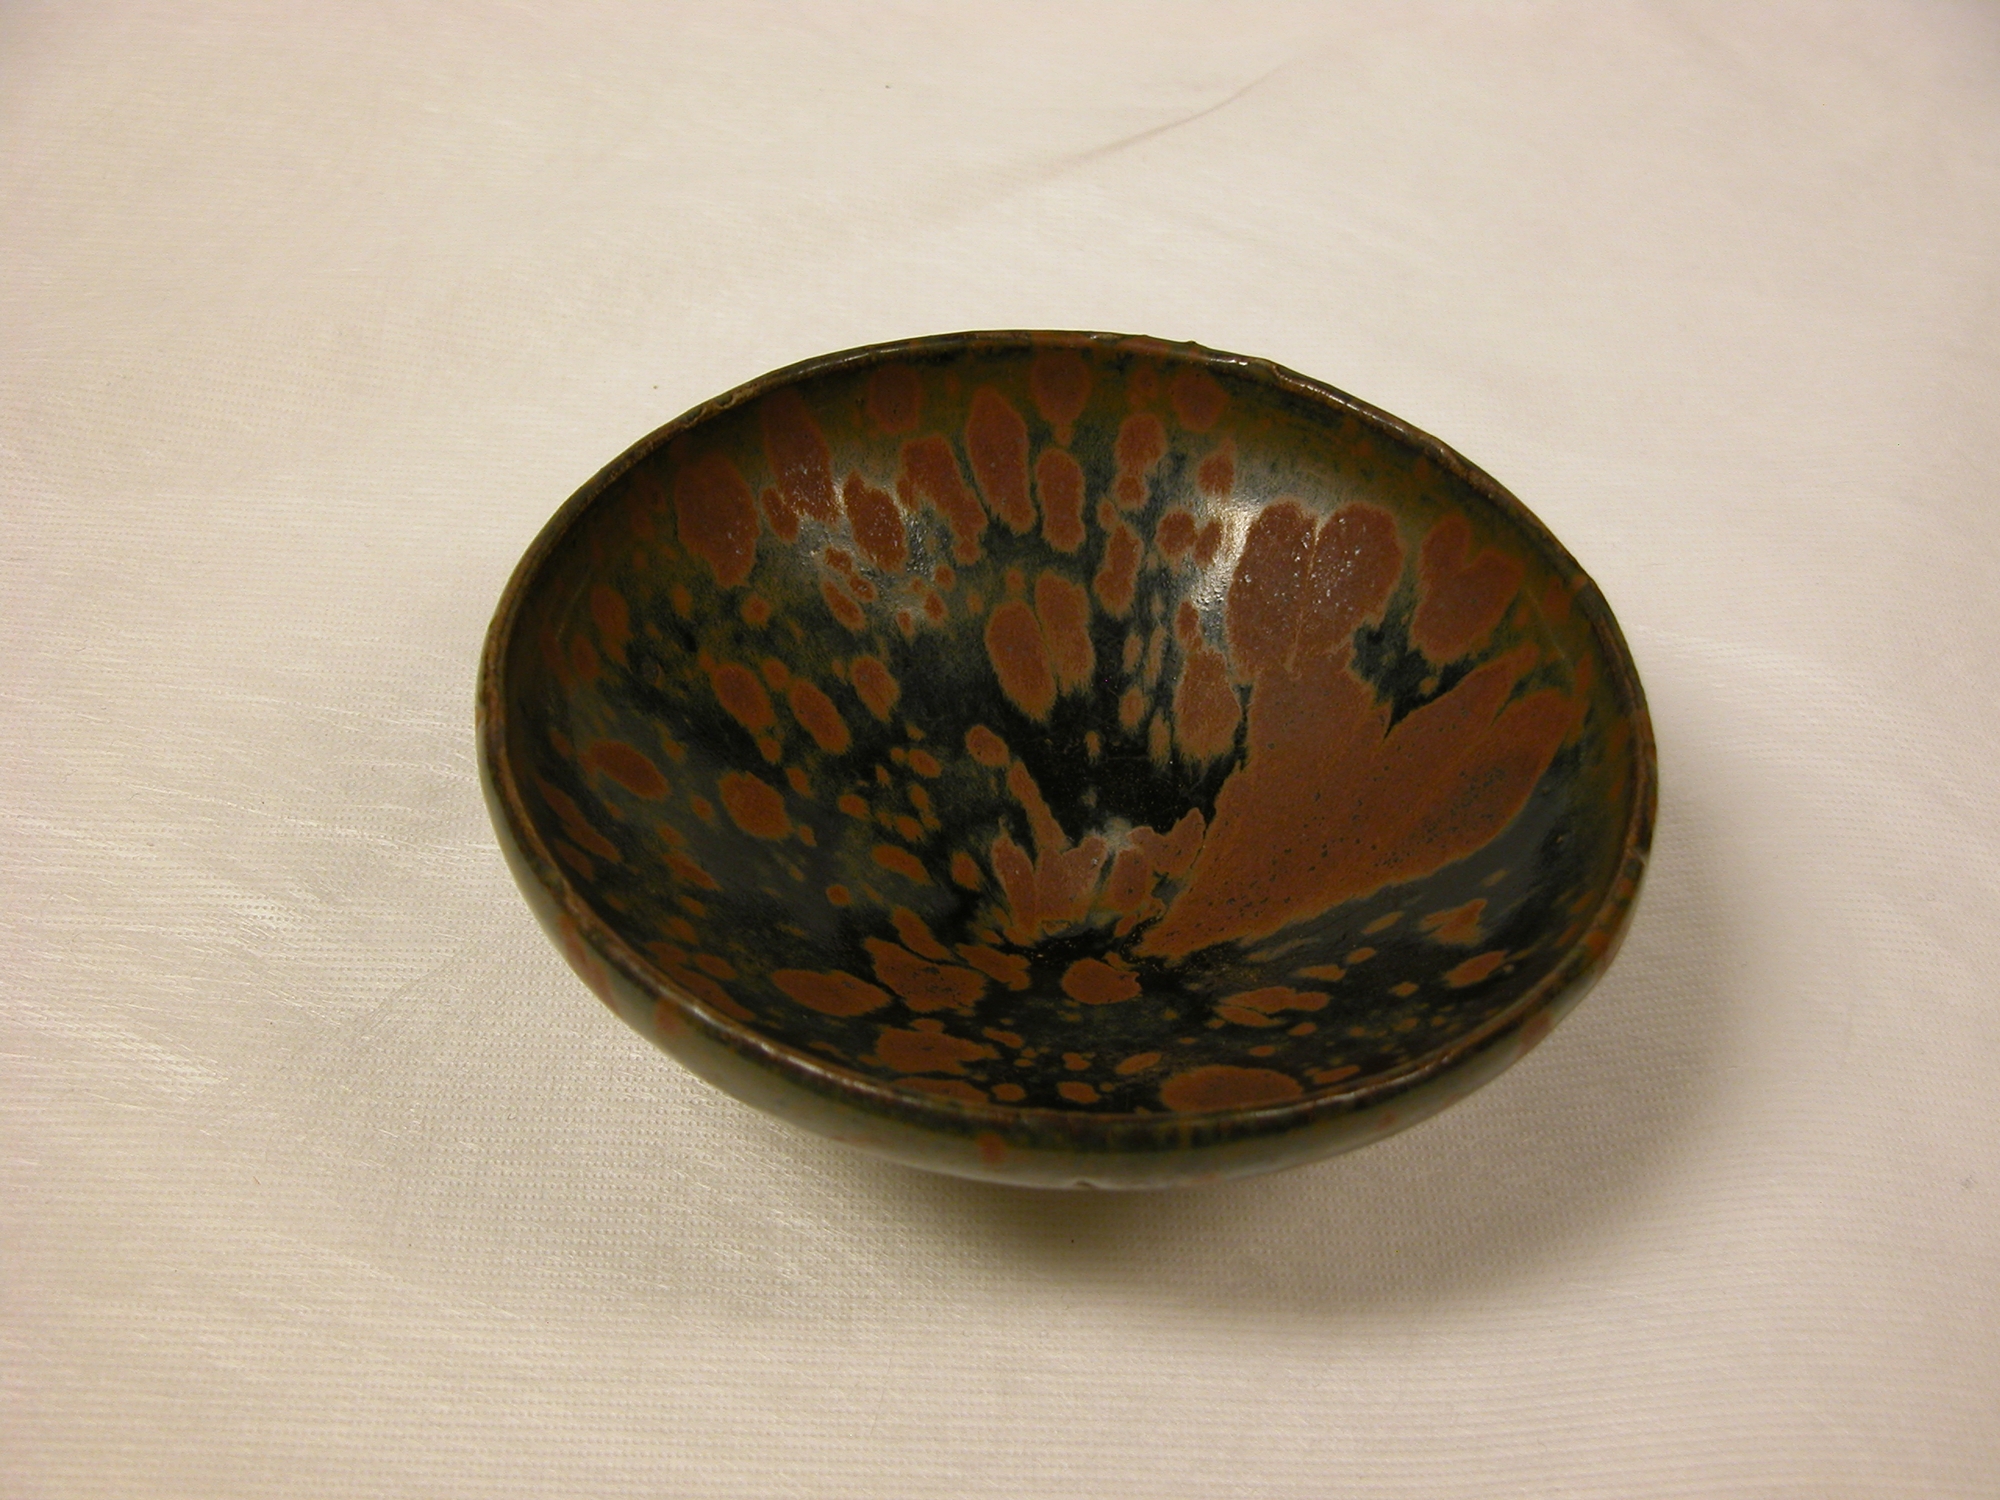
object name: bowl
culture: chinese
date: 960-1279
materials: pottery